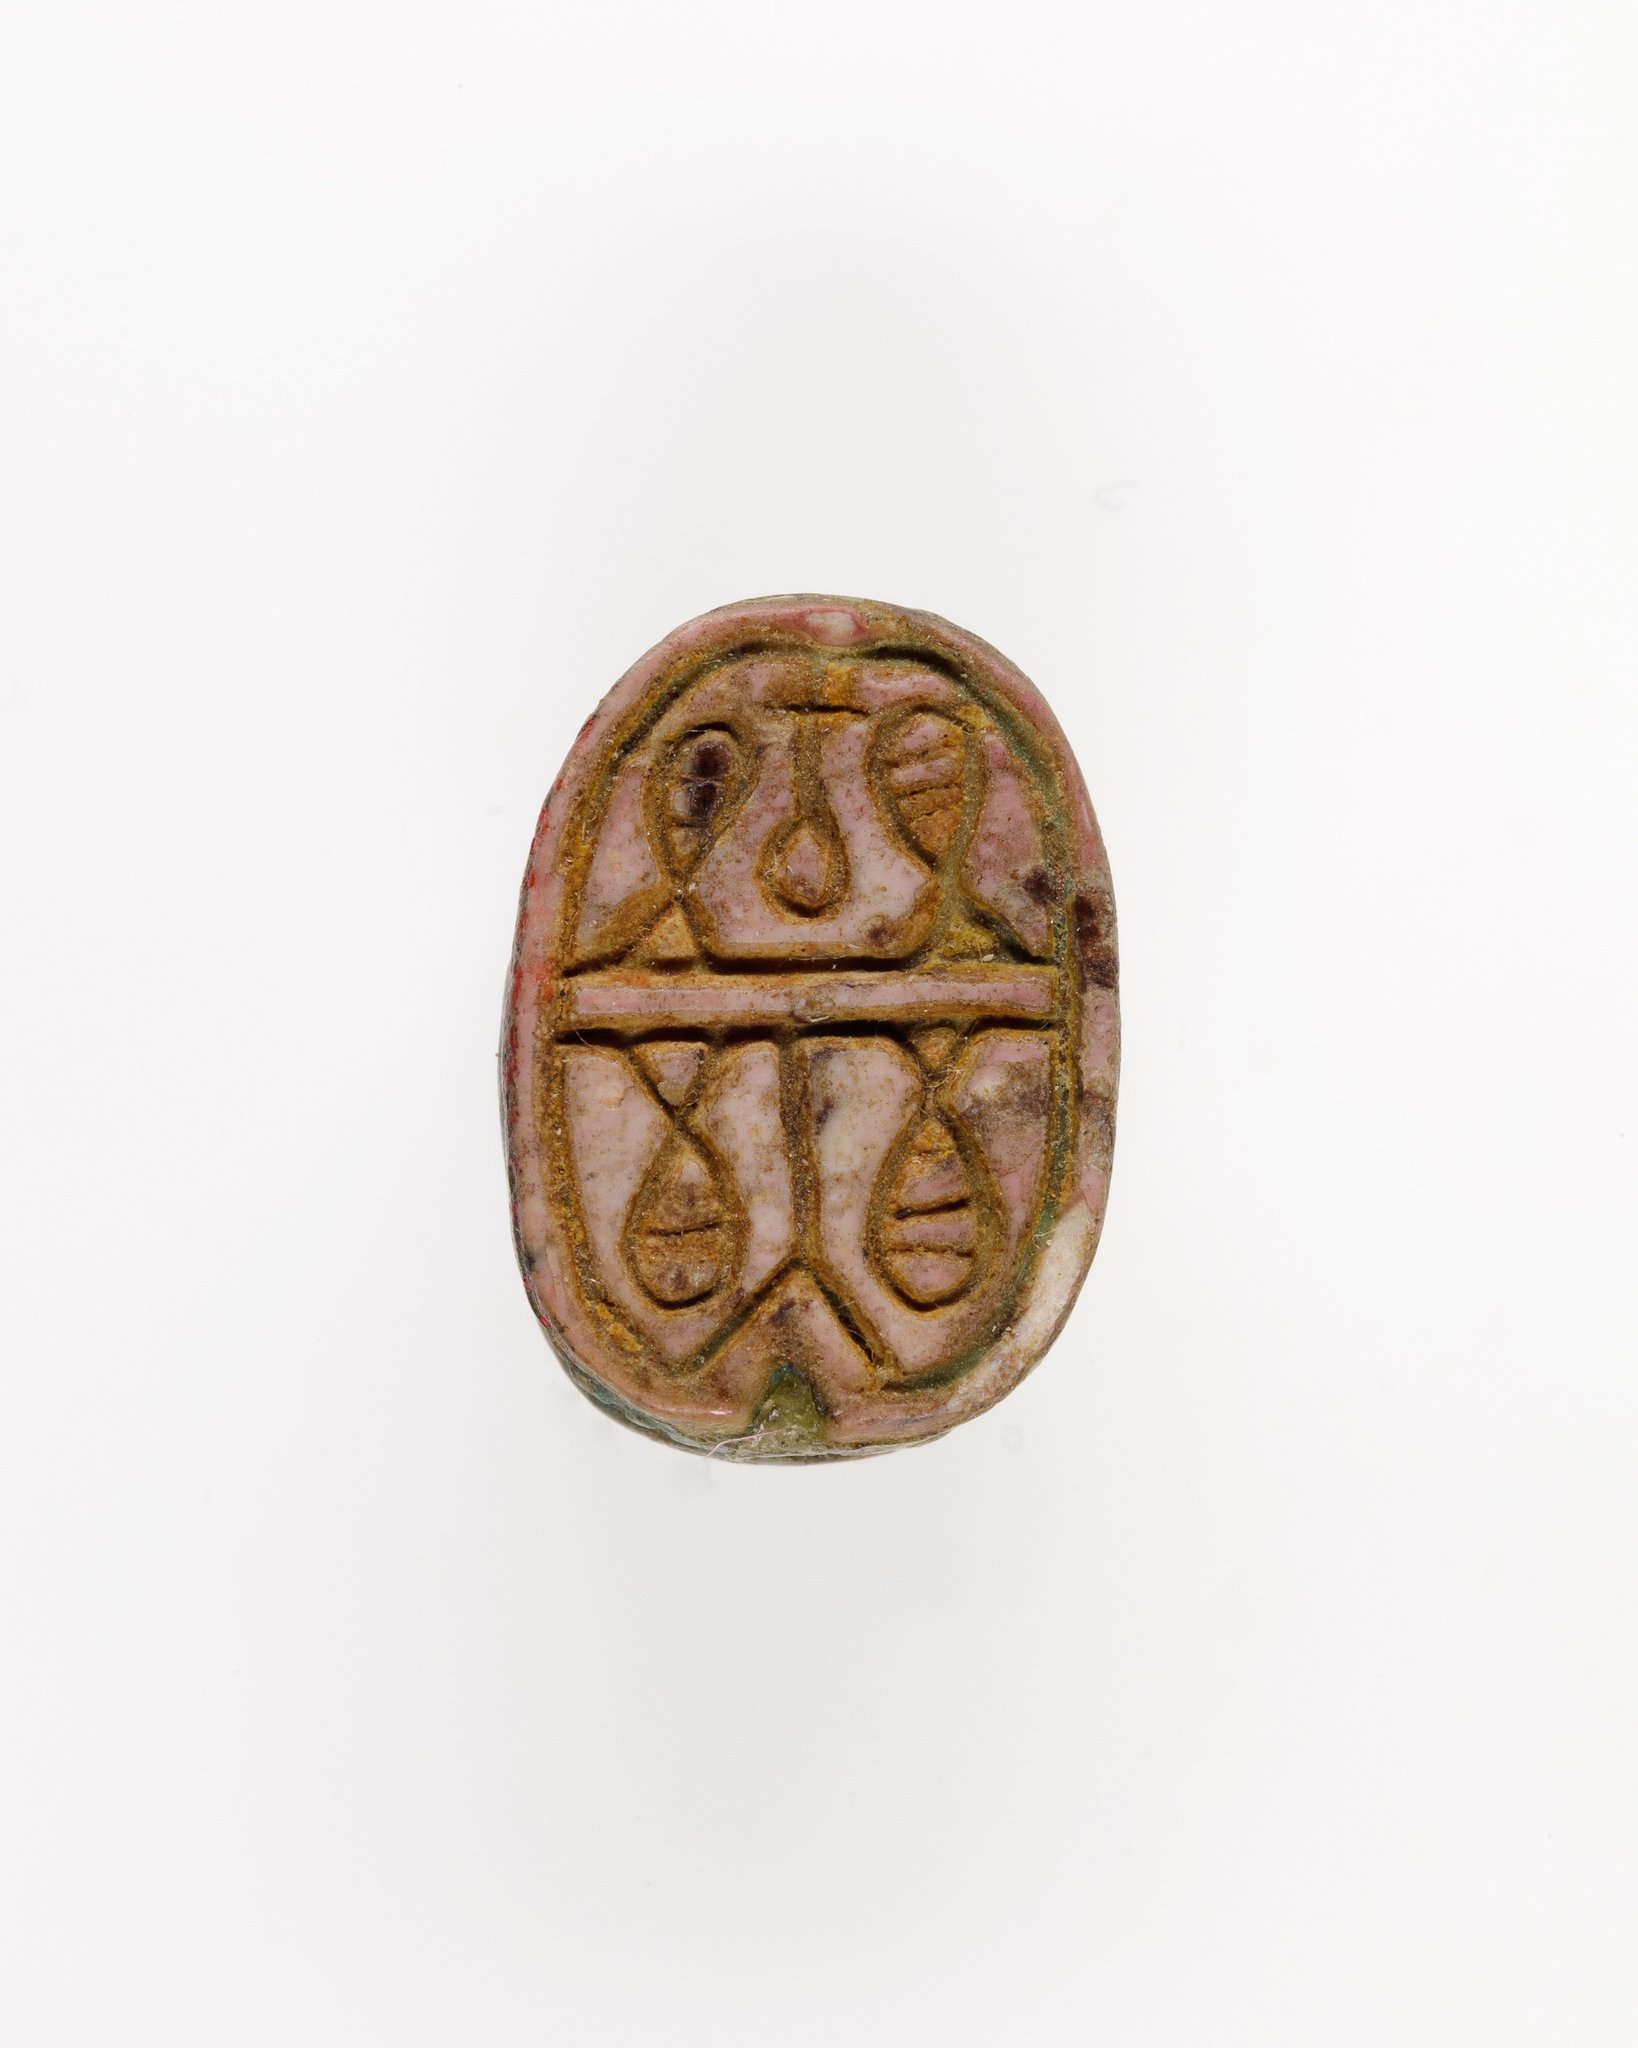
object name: scarab, hieroglyph, sa, nefer, lotus stem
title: Scarab Inscribed with Hieroglyphs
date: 1850-1640 BCE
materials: stone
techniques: glazing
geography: egypt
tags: scarabs